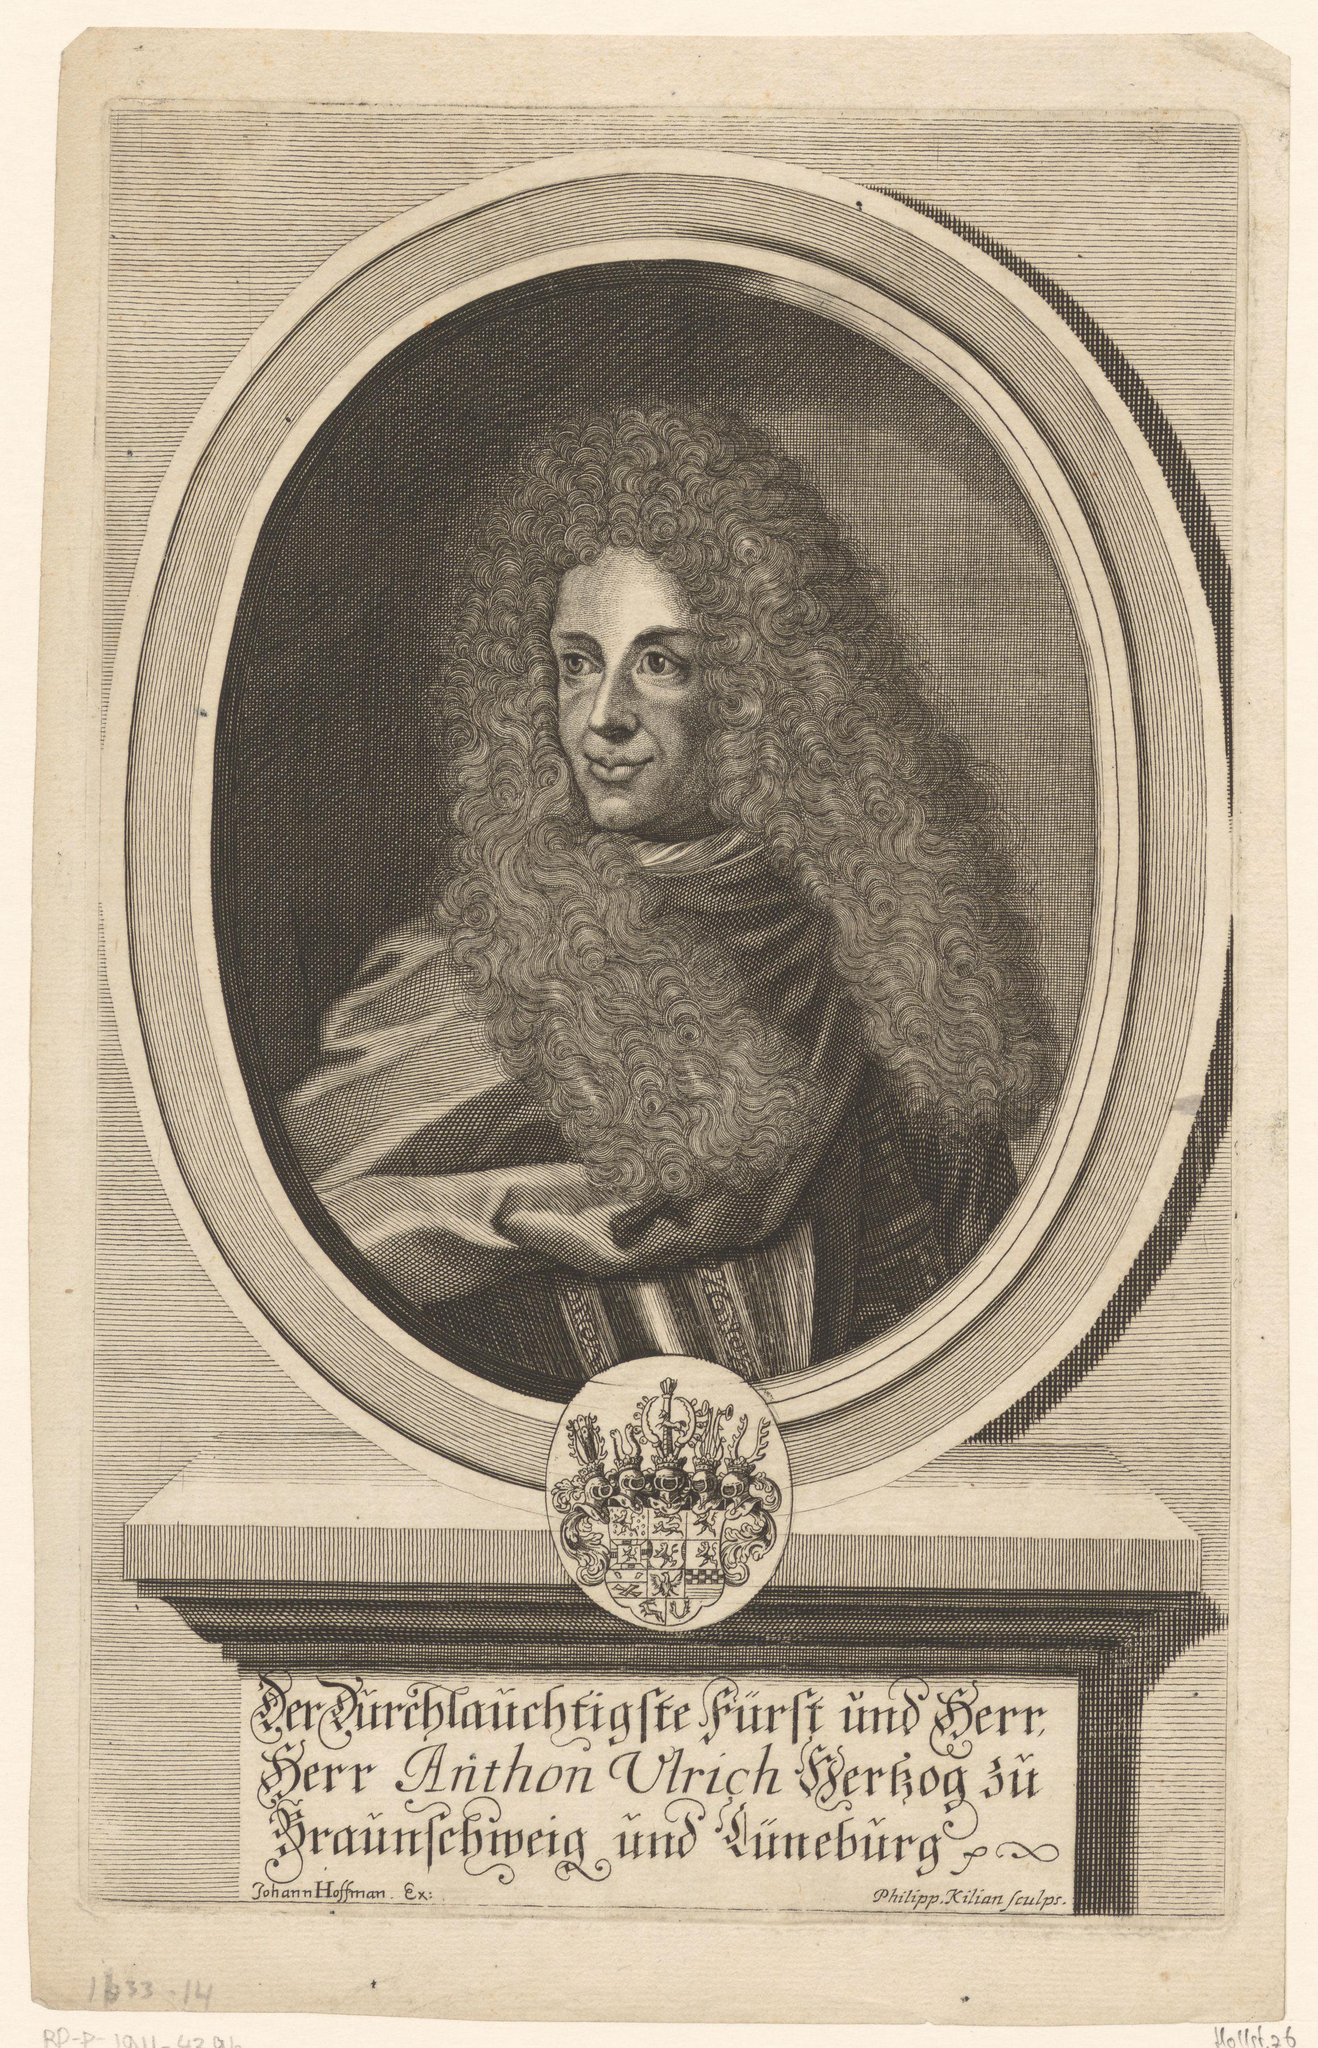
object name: print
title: Portret van Anton Ulrich von Braunschweig-Lüneburg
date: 1643-1693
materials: paper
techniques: engraving, etching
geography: nuremberg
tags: historical persons, writer, poet, author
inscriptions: collector's mark: Lugt 2228